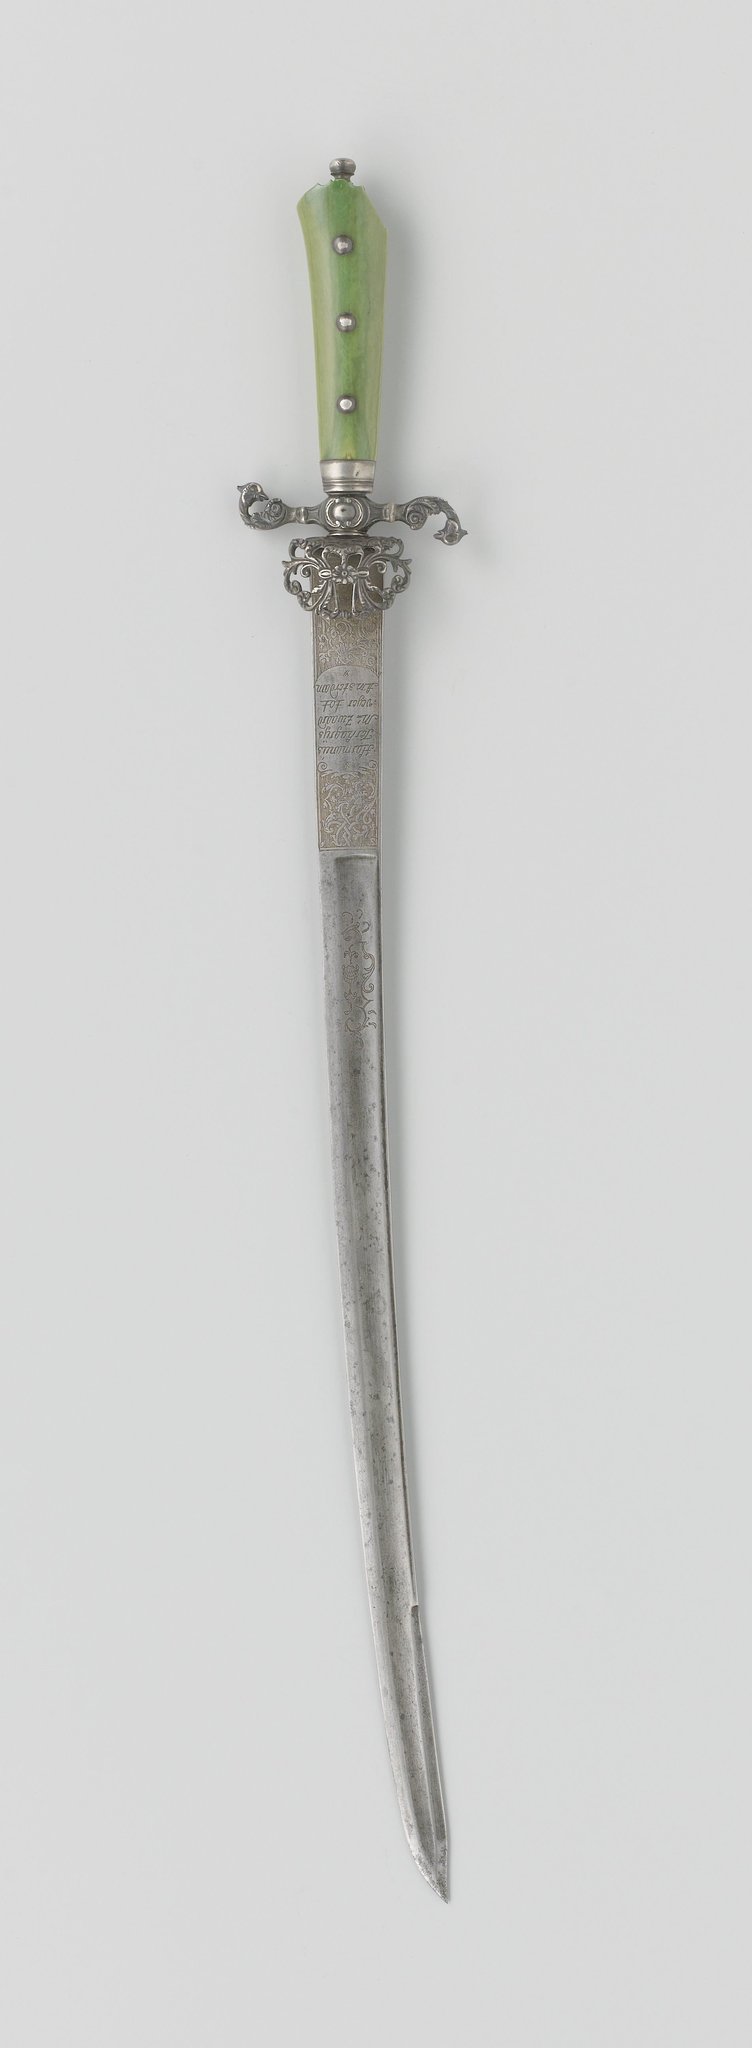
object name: hunting hanger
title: Hartsvanger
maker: harmanus ferhagrijs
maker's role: smid, zwaardveger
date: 1775-1799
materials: ivory, silver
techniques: engraving, etching, sawing, striking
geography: amsterdam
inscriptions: signature: ‘Harmanus // Ferhagrijs // Mr Zwaard // veger tot // Amsterdam’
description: Hartsvanger of jachtzwaard genaamd. Het assymetrische gevest heeft een groen gemaakte ivoren greep in de vorm van het heft van een mes met drie sierknoppen alsof het klinknagels zijn, en is met zilver beslagen, waaronder een stootplaat, uitgezaagd en gegraveerd om op een bos krullend lofwerk te lijken en een pareerstang die aan beide zijden eindigt in een vogelkop. De gekromde kling is aan weerszijden geëtst met een signatuur omlijst door arabesken en heeft een brede geul, aan de bovenkant geëtst met een fruitslinger tussen bladerranken, en een smallere à la Montmorency.